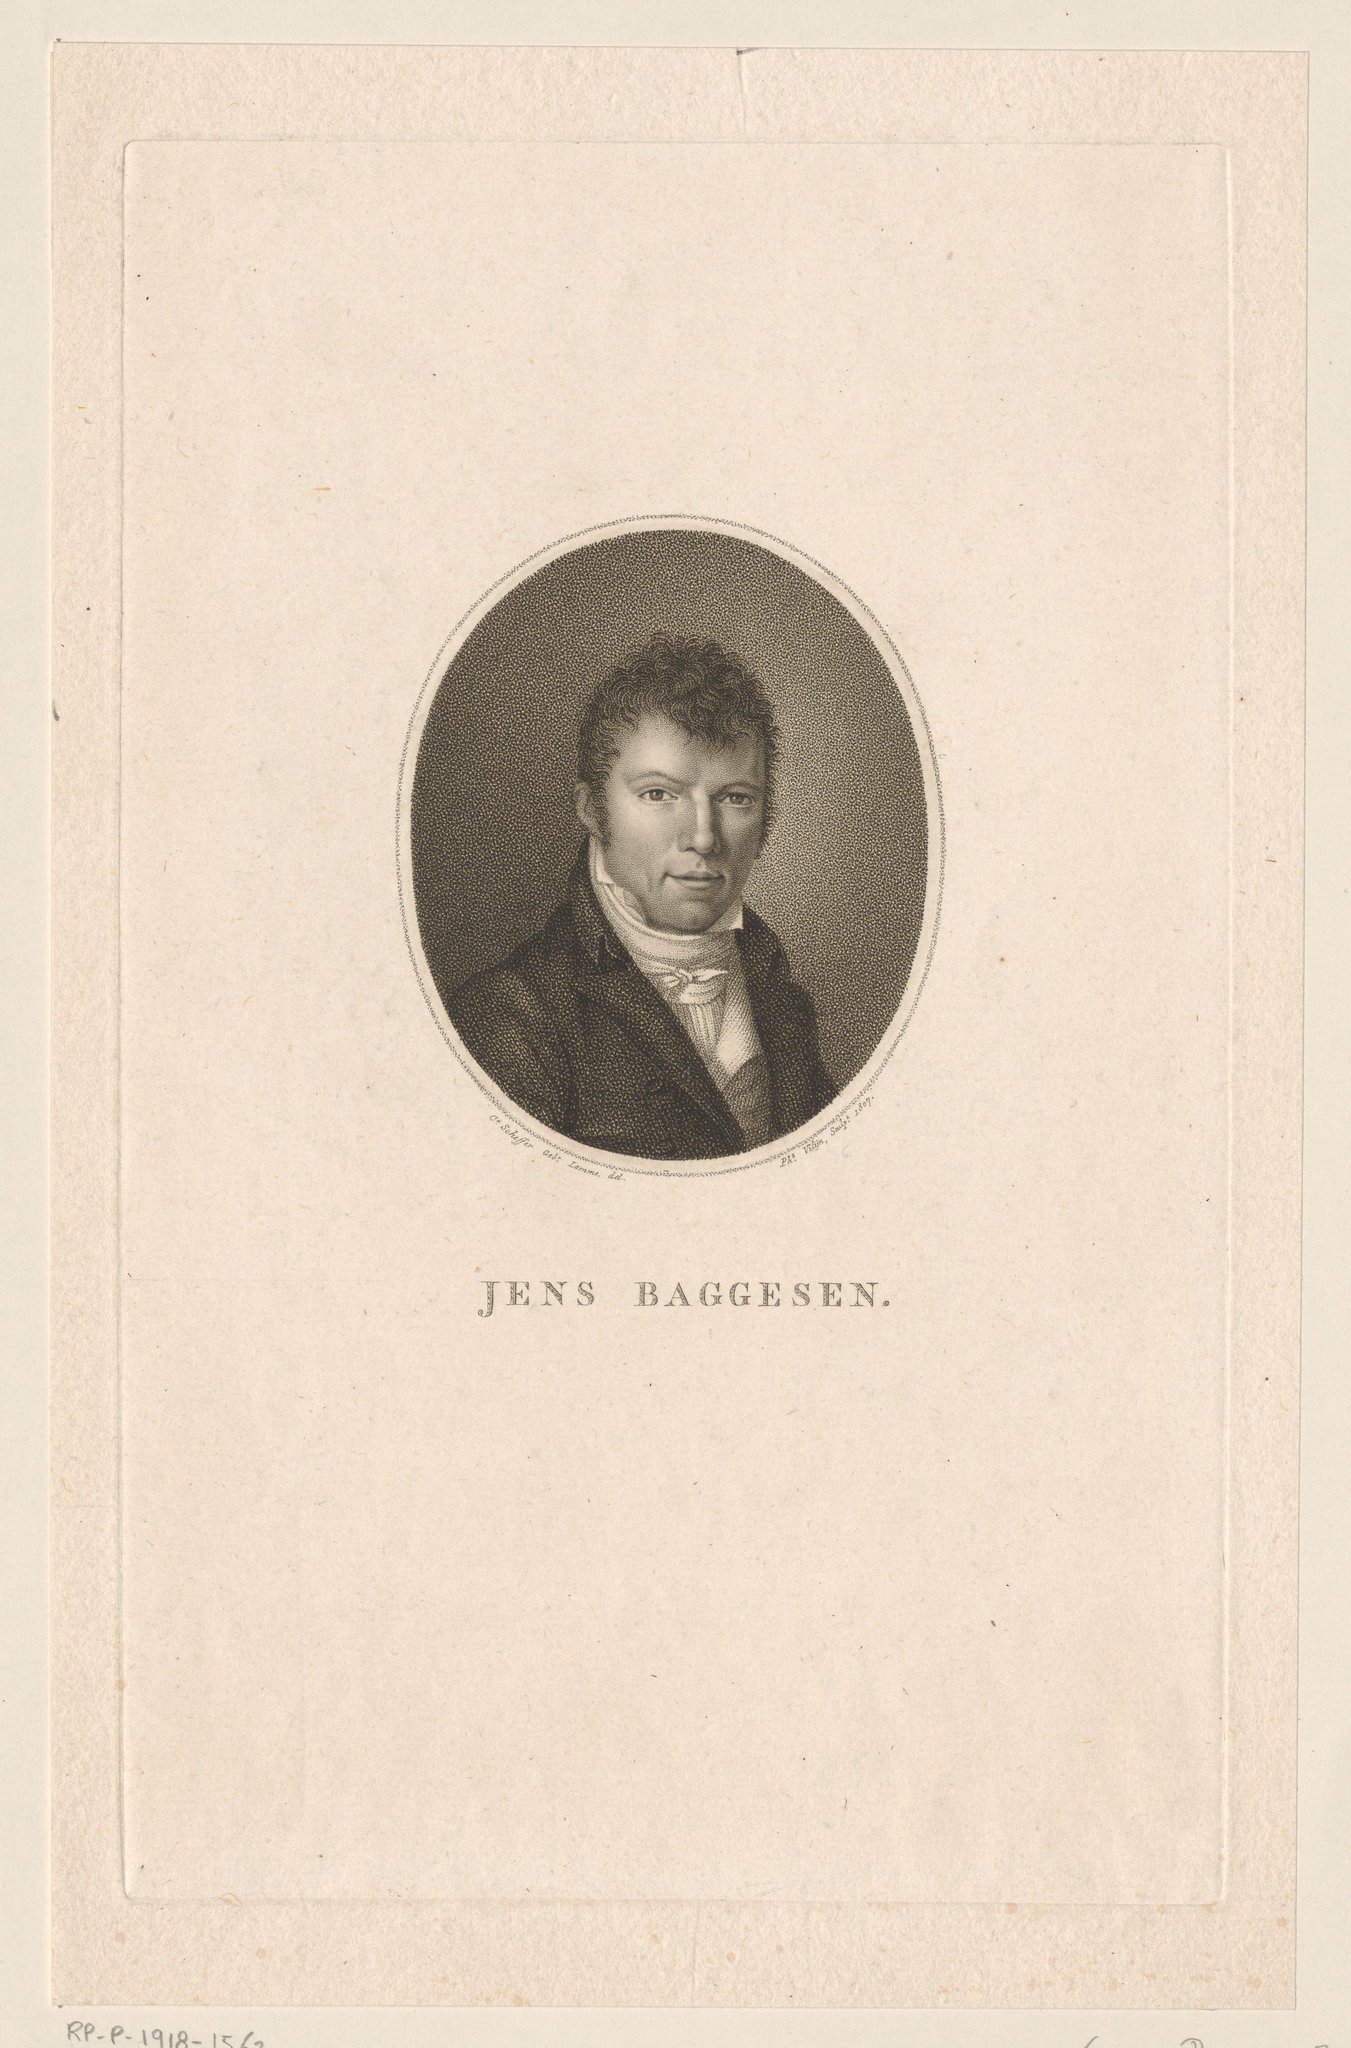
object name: print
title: Portret van Jens Immanuel Baggesen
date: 1807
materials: paper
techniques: etching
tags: historical persons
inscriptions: collector's mark: Lugt 2233